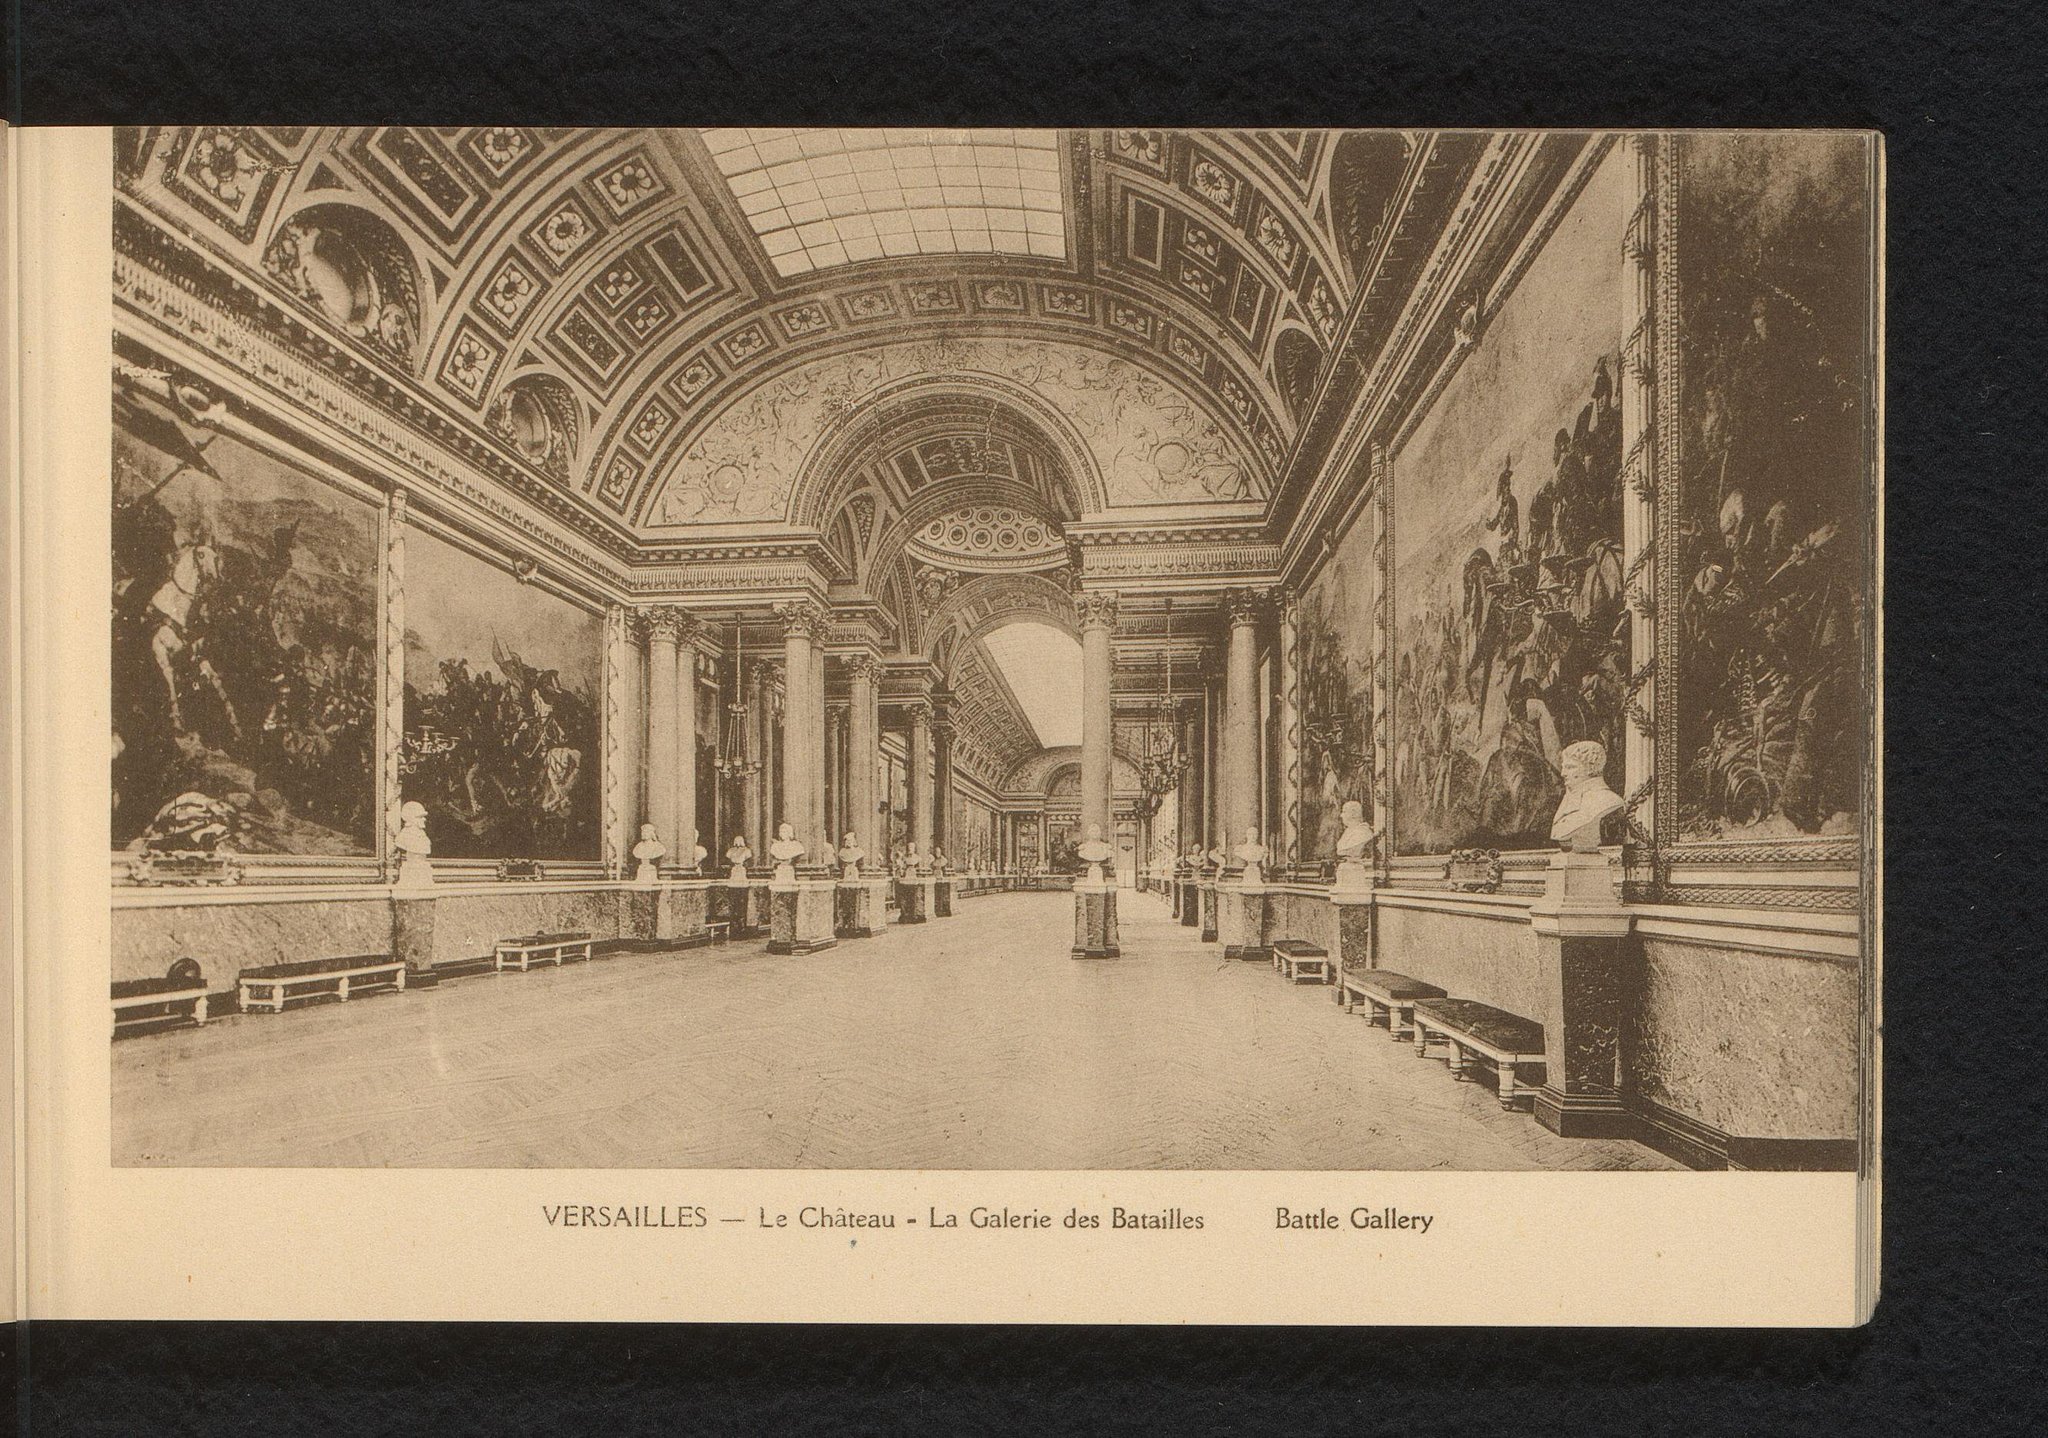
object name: photomechanical print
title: Versailles. Le Château. La Galerie des Batailles / Battle Gallery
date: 1919-1930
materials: cardboard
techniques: photograph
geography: paris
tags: decorations (interior of the house), palace, interior ~ representation of a building